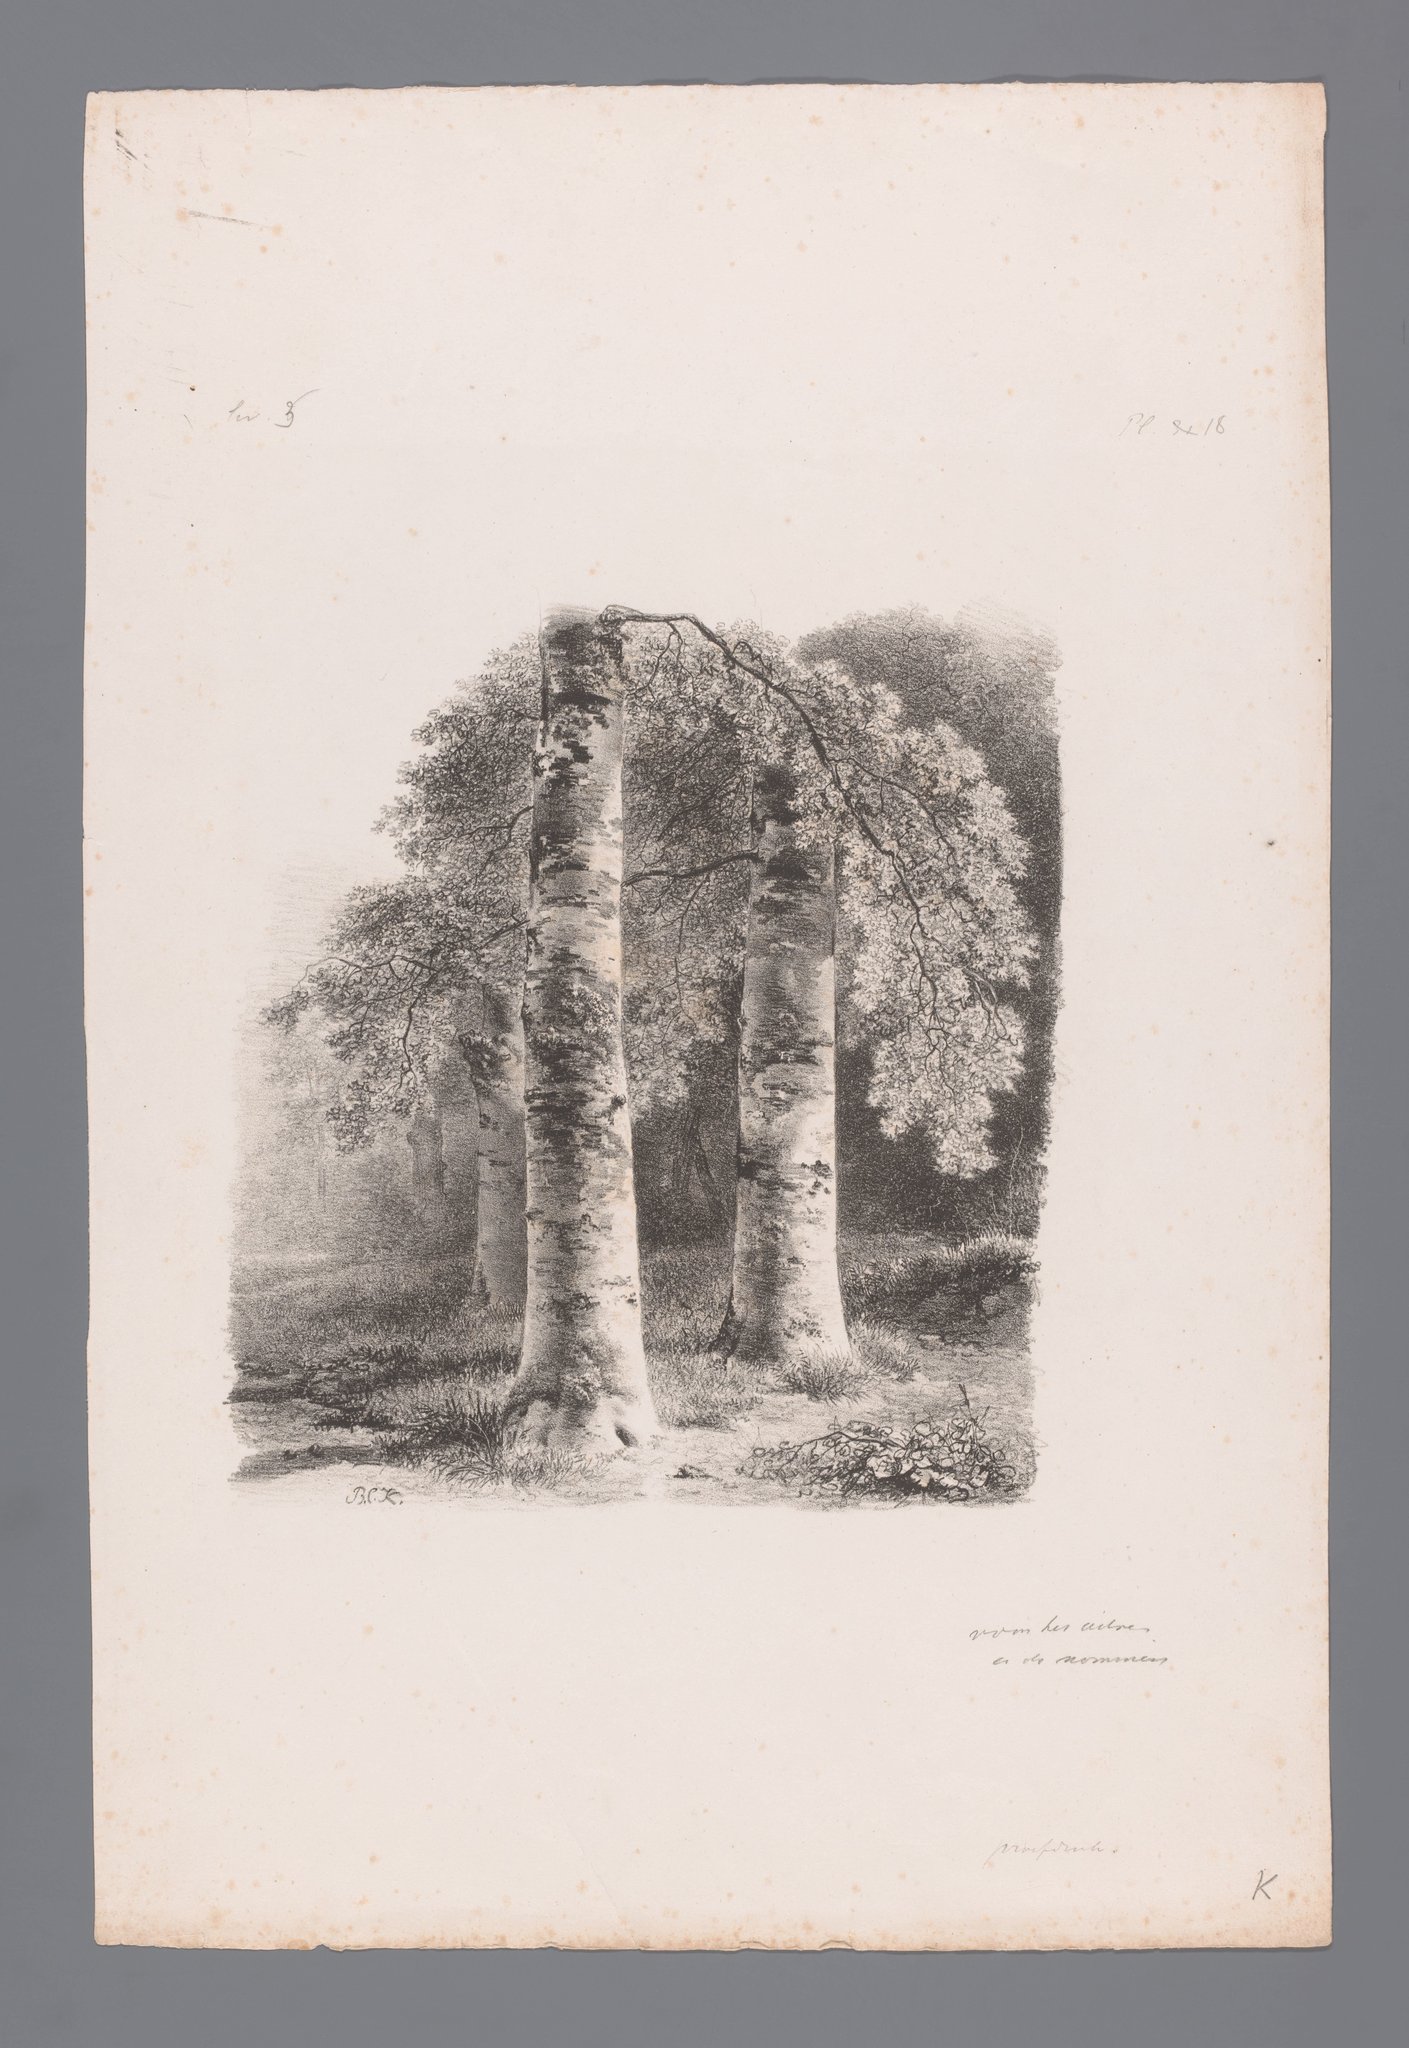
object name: print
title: Berkenbomen in het bos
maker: barend cornelis koekkoek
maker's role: draughtsman, painter, print maker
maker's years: 1803-1862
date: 1829-1845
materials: paper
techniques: lithograph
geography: amsterdam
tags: groups of trees, trees: birch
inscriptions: collector's mark: Lugt 2228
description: In 1829 en 1830 gaf Koekkoek, samen met Daiwaille, zes cahiers uit met ieder zes prenten getiteld Landschapstudiën. Deze werden gebruikt in het tekenonderwijs. Vijftien jaar later werd deze reeks, in een andere samenstelling nogmaals uitgegeven door Meyer en Comp in Amsterdam. Zie: De Bruyn Kops, 1963.